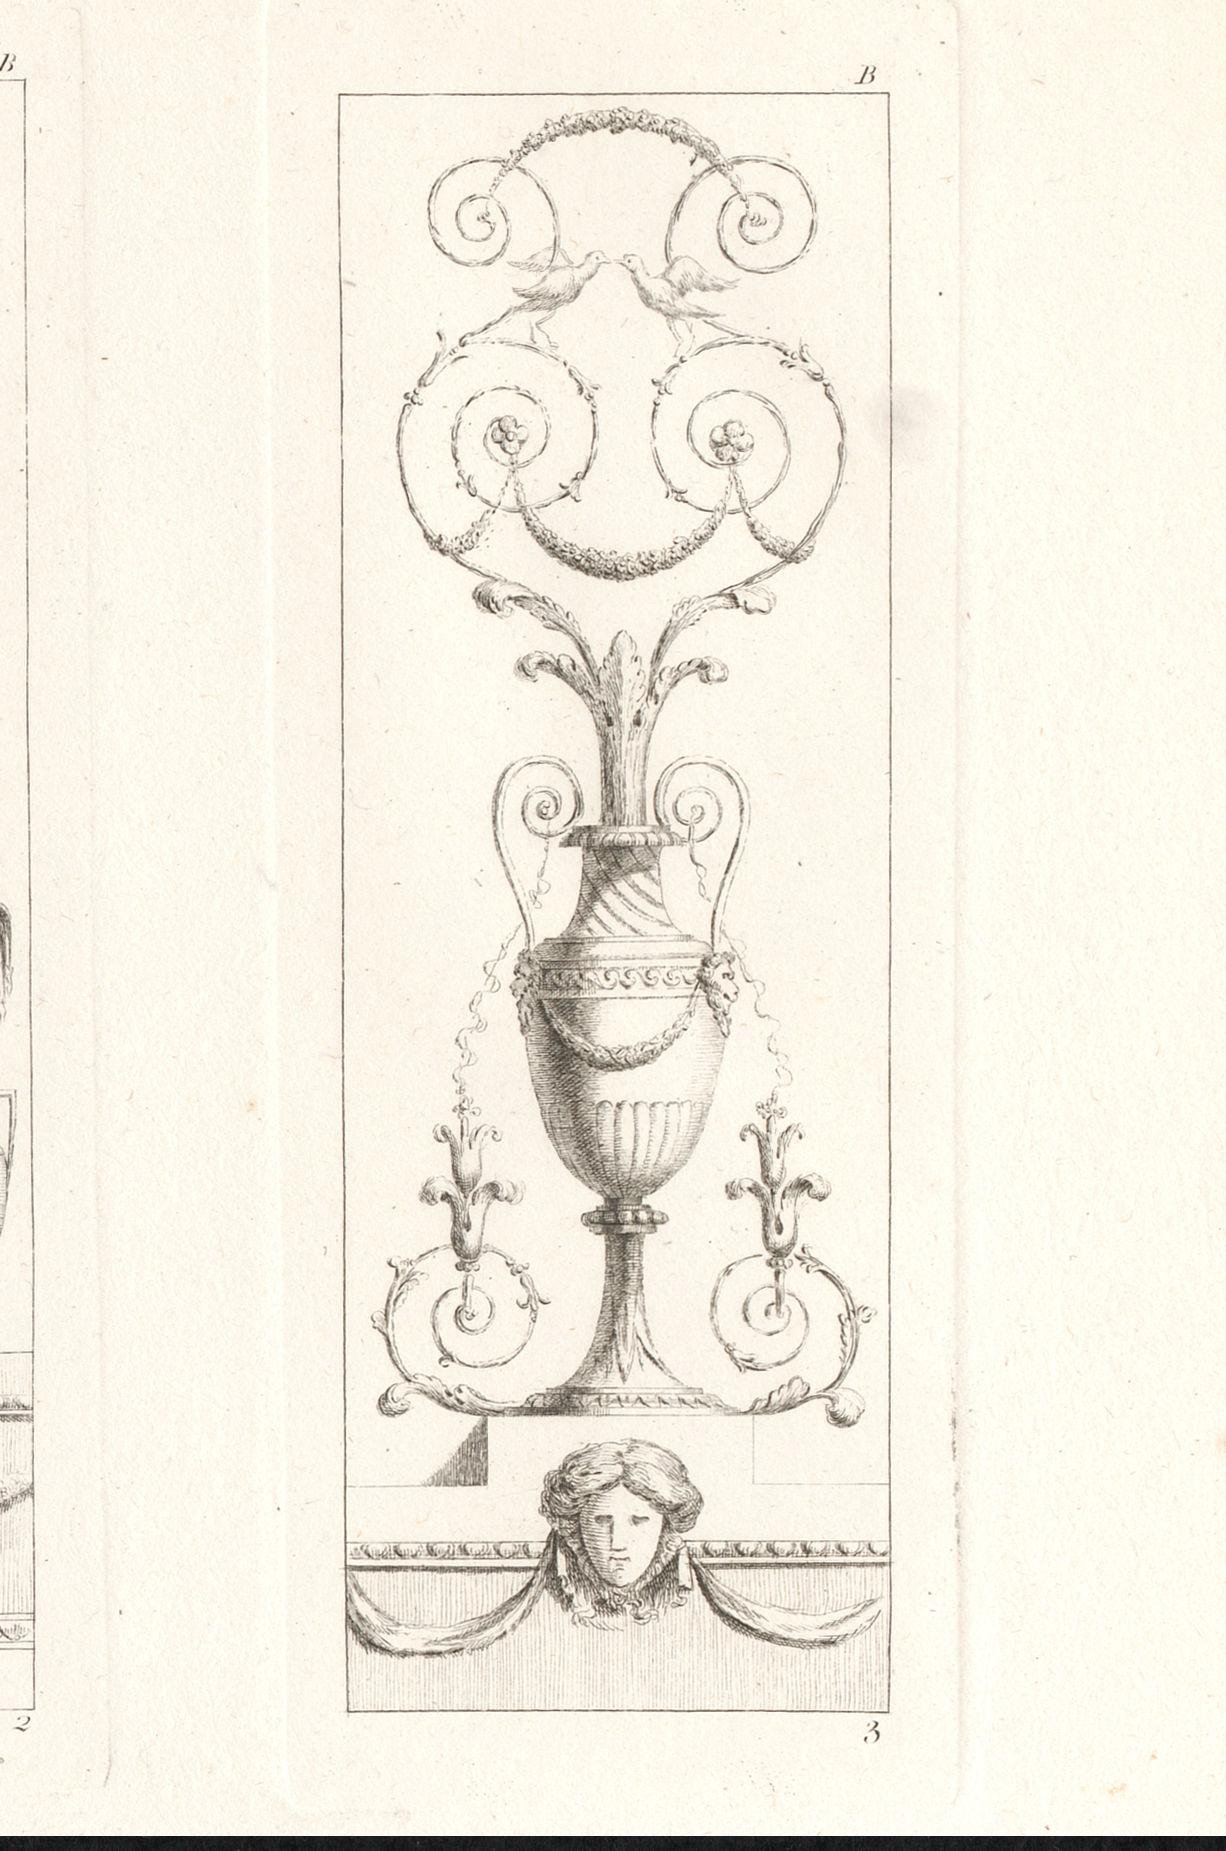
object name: ornament print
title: Ornamentele vaas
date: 1802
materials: paper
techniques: etching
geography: paris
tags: ornament ~ arabesque, vase ~ ornament, mask, mascaron ~ ornament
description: Doordat dit album bestaat uit meerdere, deels eerder uitgegeven prentreeksen, is de datering niet consequent. Het geheel is op de titelpagina gedateerd op 1802. Deze reeks is niet los gedateerd. De serietitel voor het gehele werk is "Recueil d'arabesques, contenant les loges du Vatican". De andere serietitel is de titel van de specifieke reeks binnen het geheel.